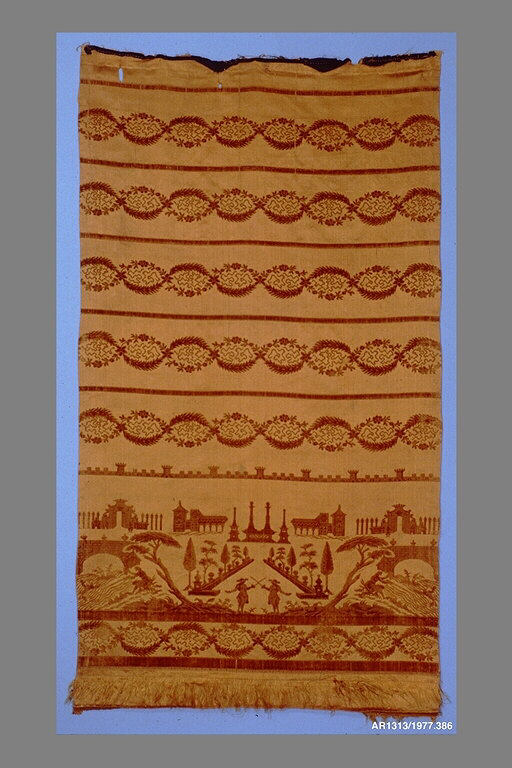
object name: length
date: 1767-1800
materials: silk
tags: human figures,buildings,trees